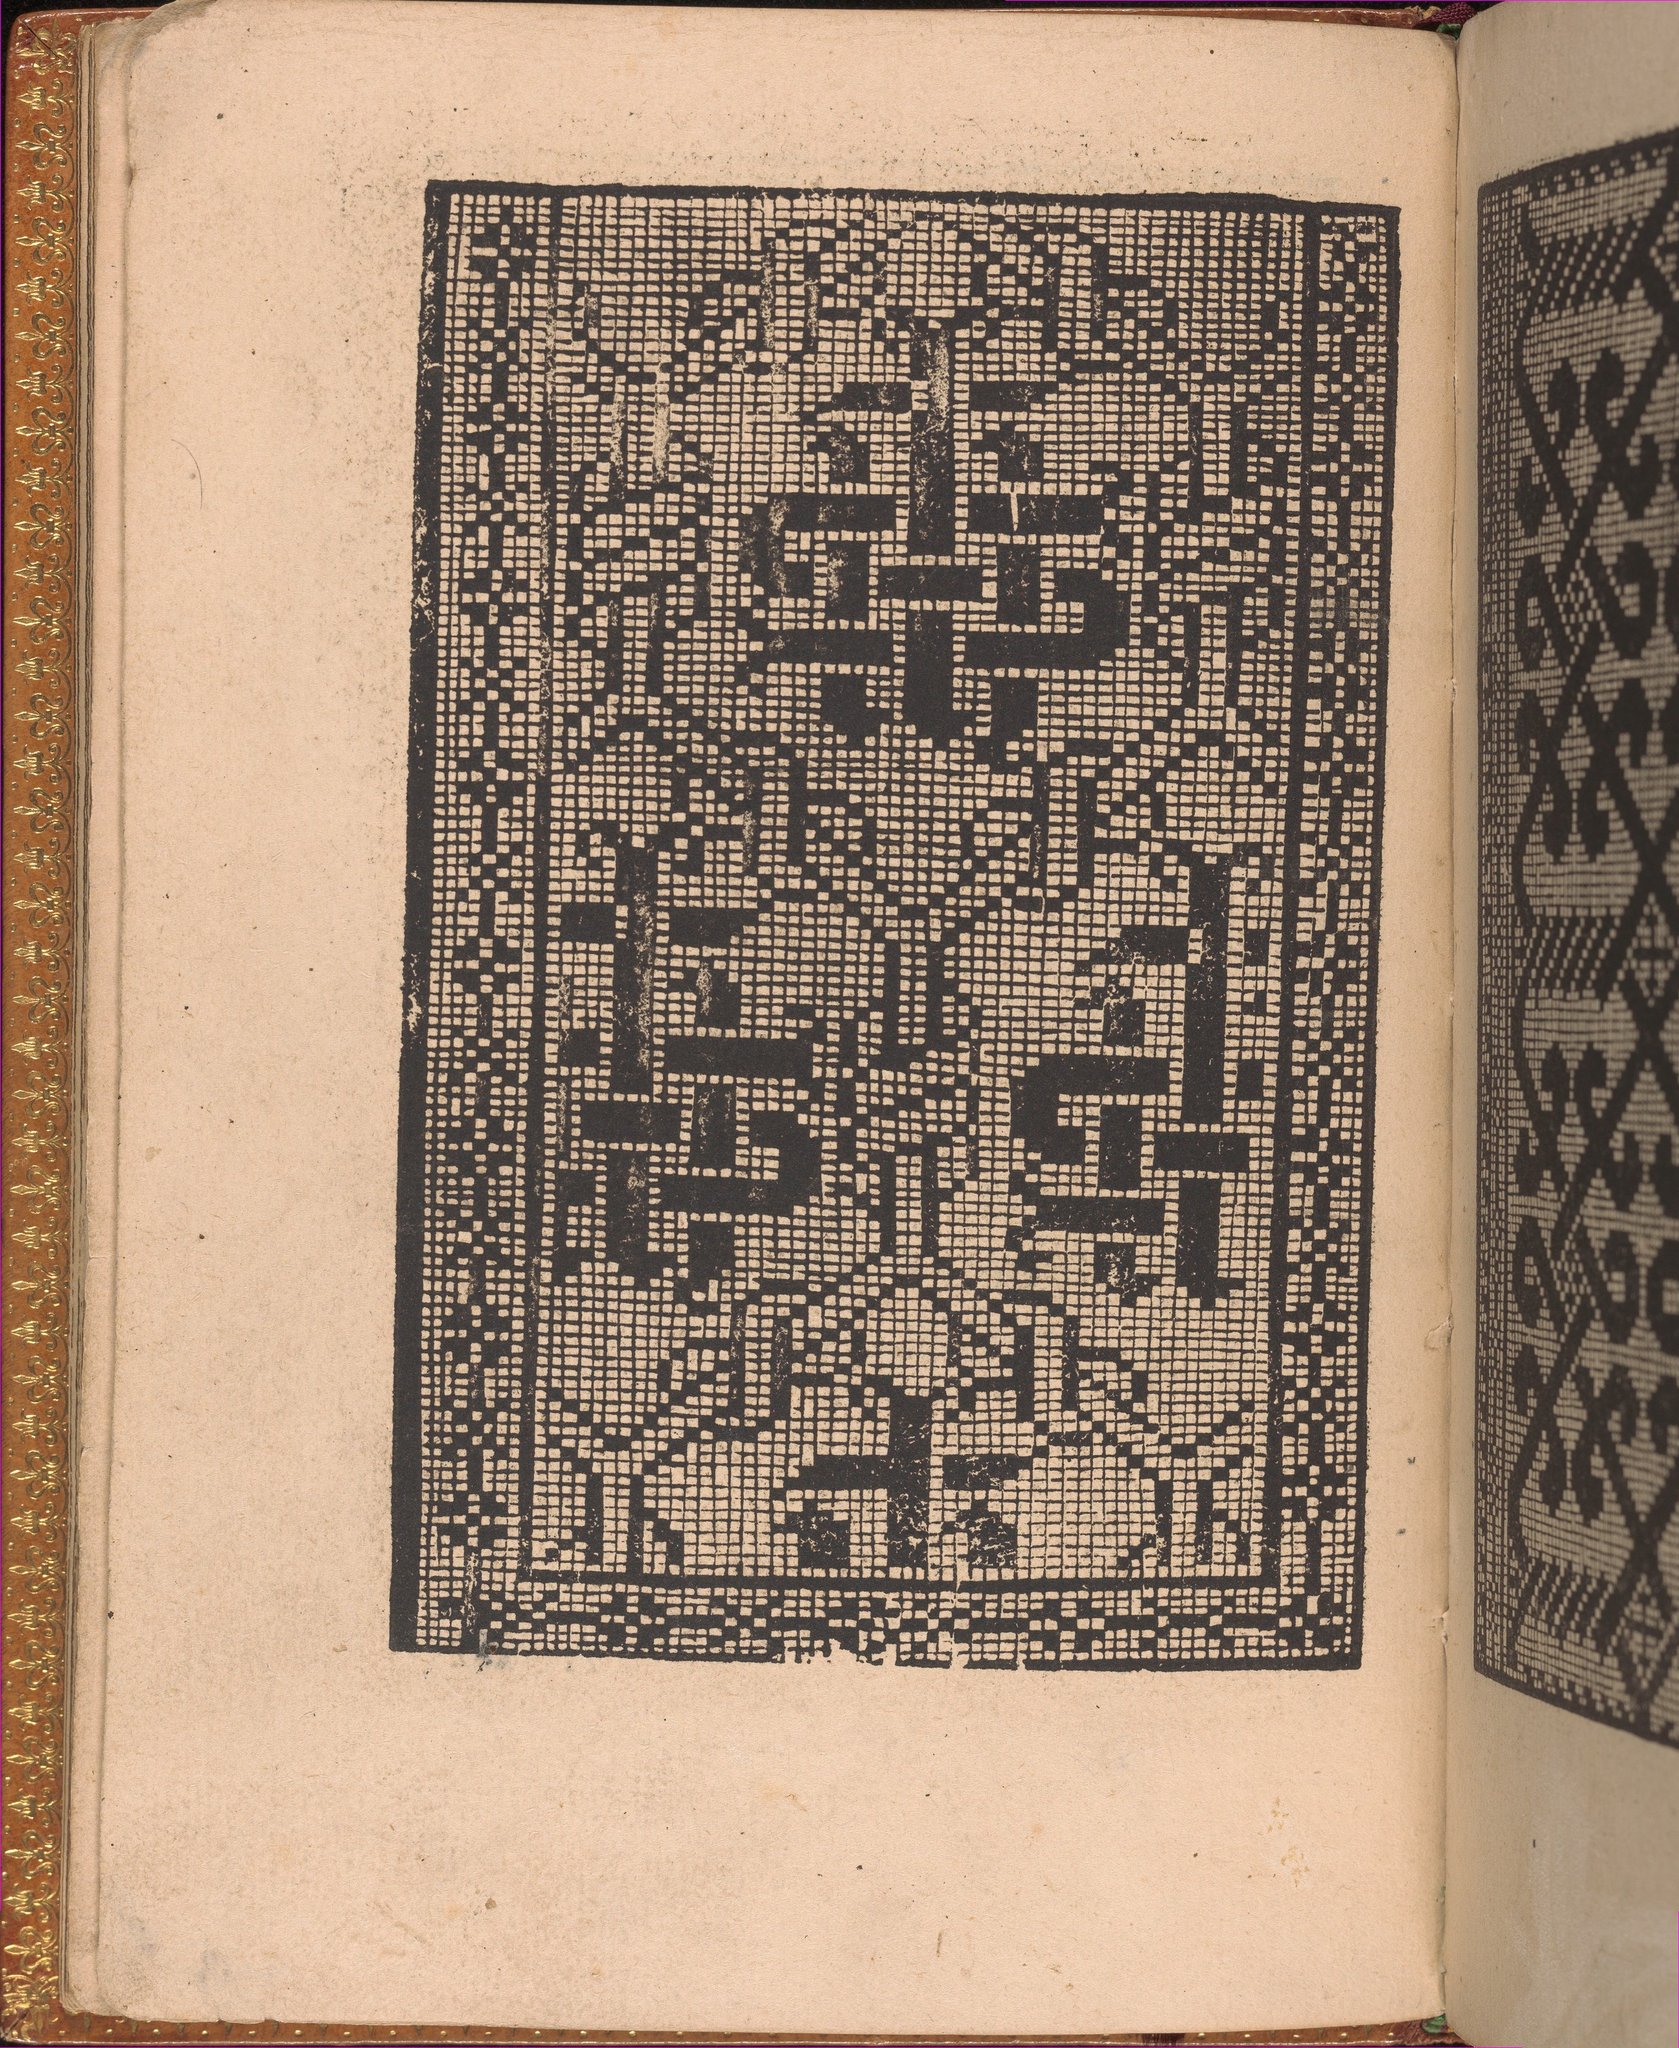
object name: book print ornament architecture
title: Convivio delle Belle Donne, page 3 (verso)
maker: nicolò zoppino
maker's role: publisher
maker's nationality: italian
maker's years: 1478-1544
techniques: woodcut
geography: italy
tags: ornament